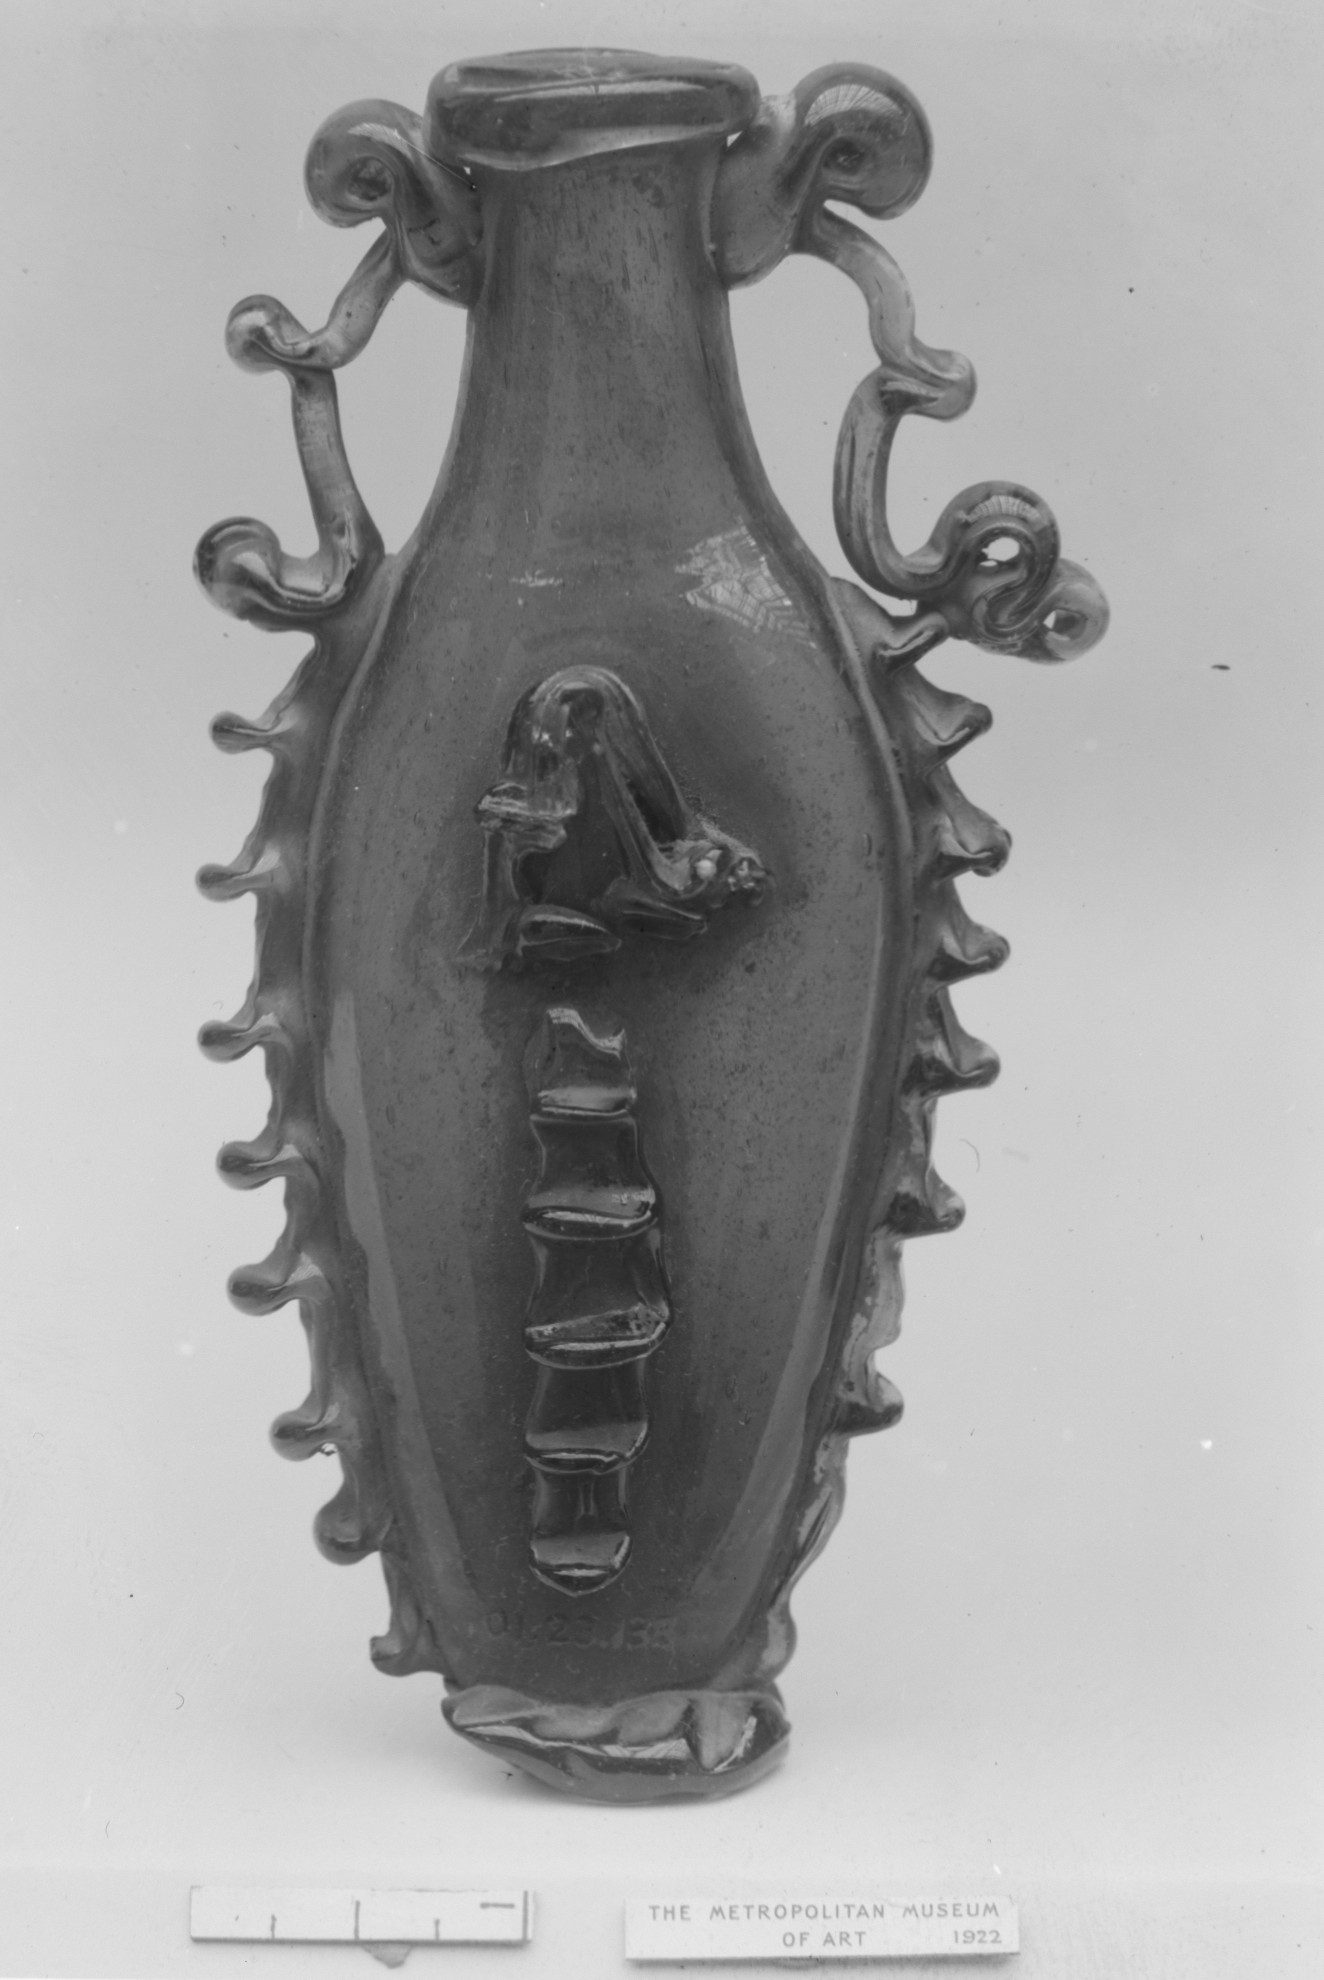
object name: bottle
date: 1701-1800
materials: glass